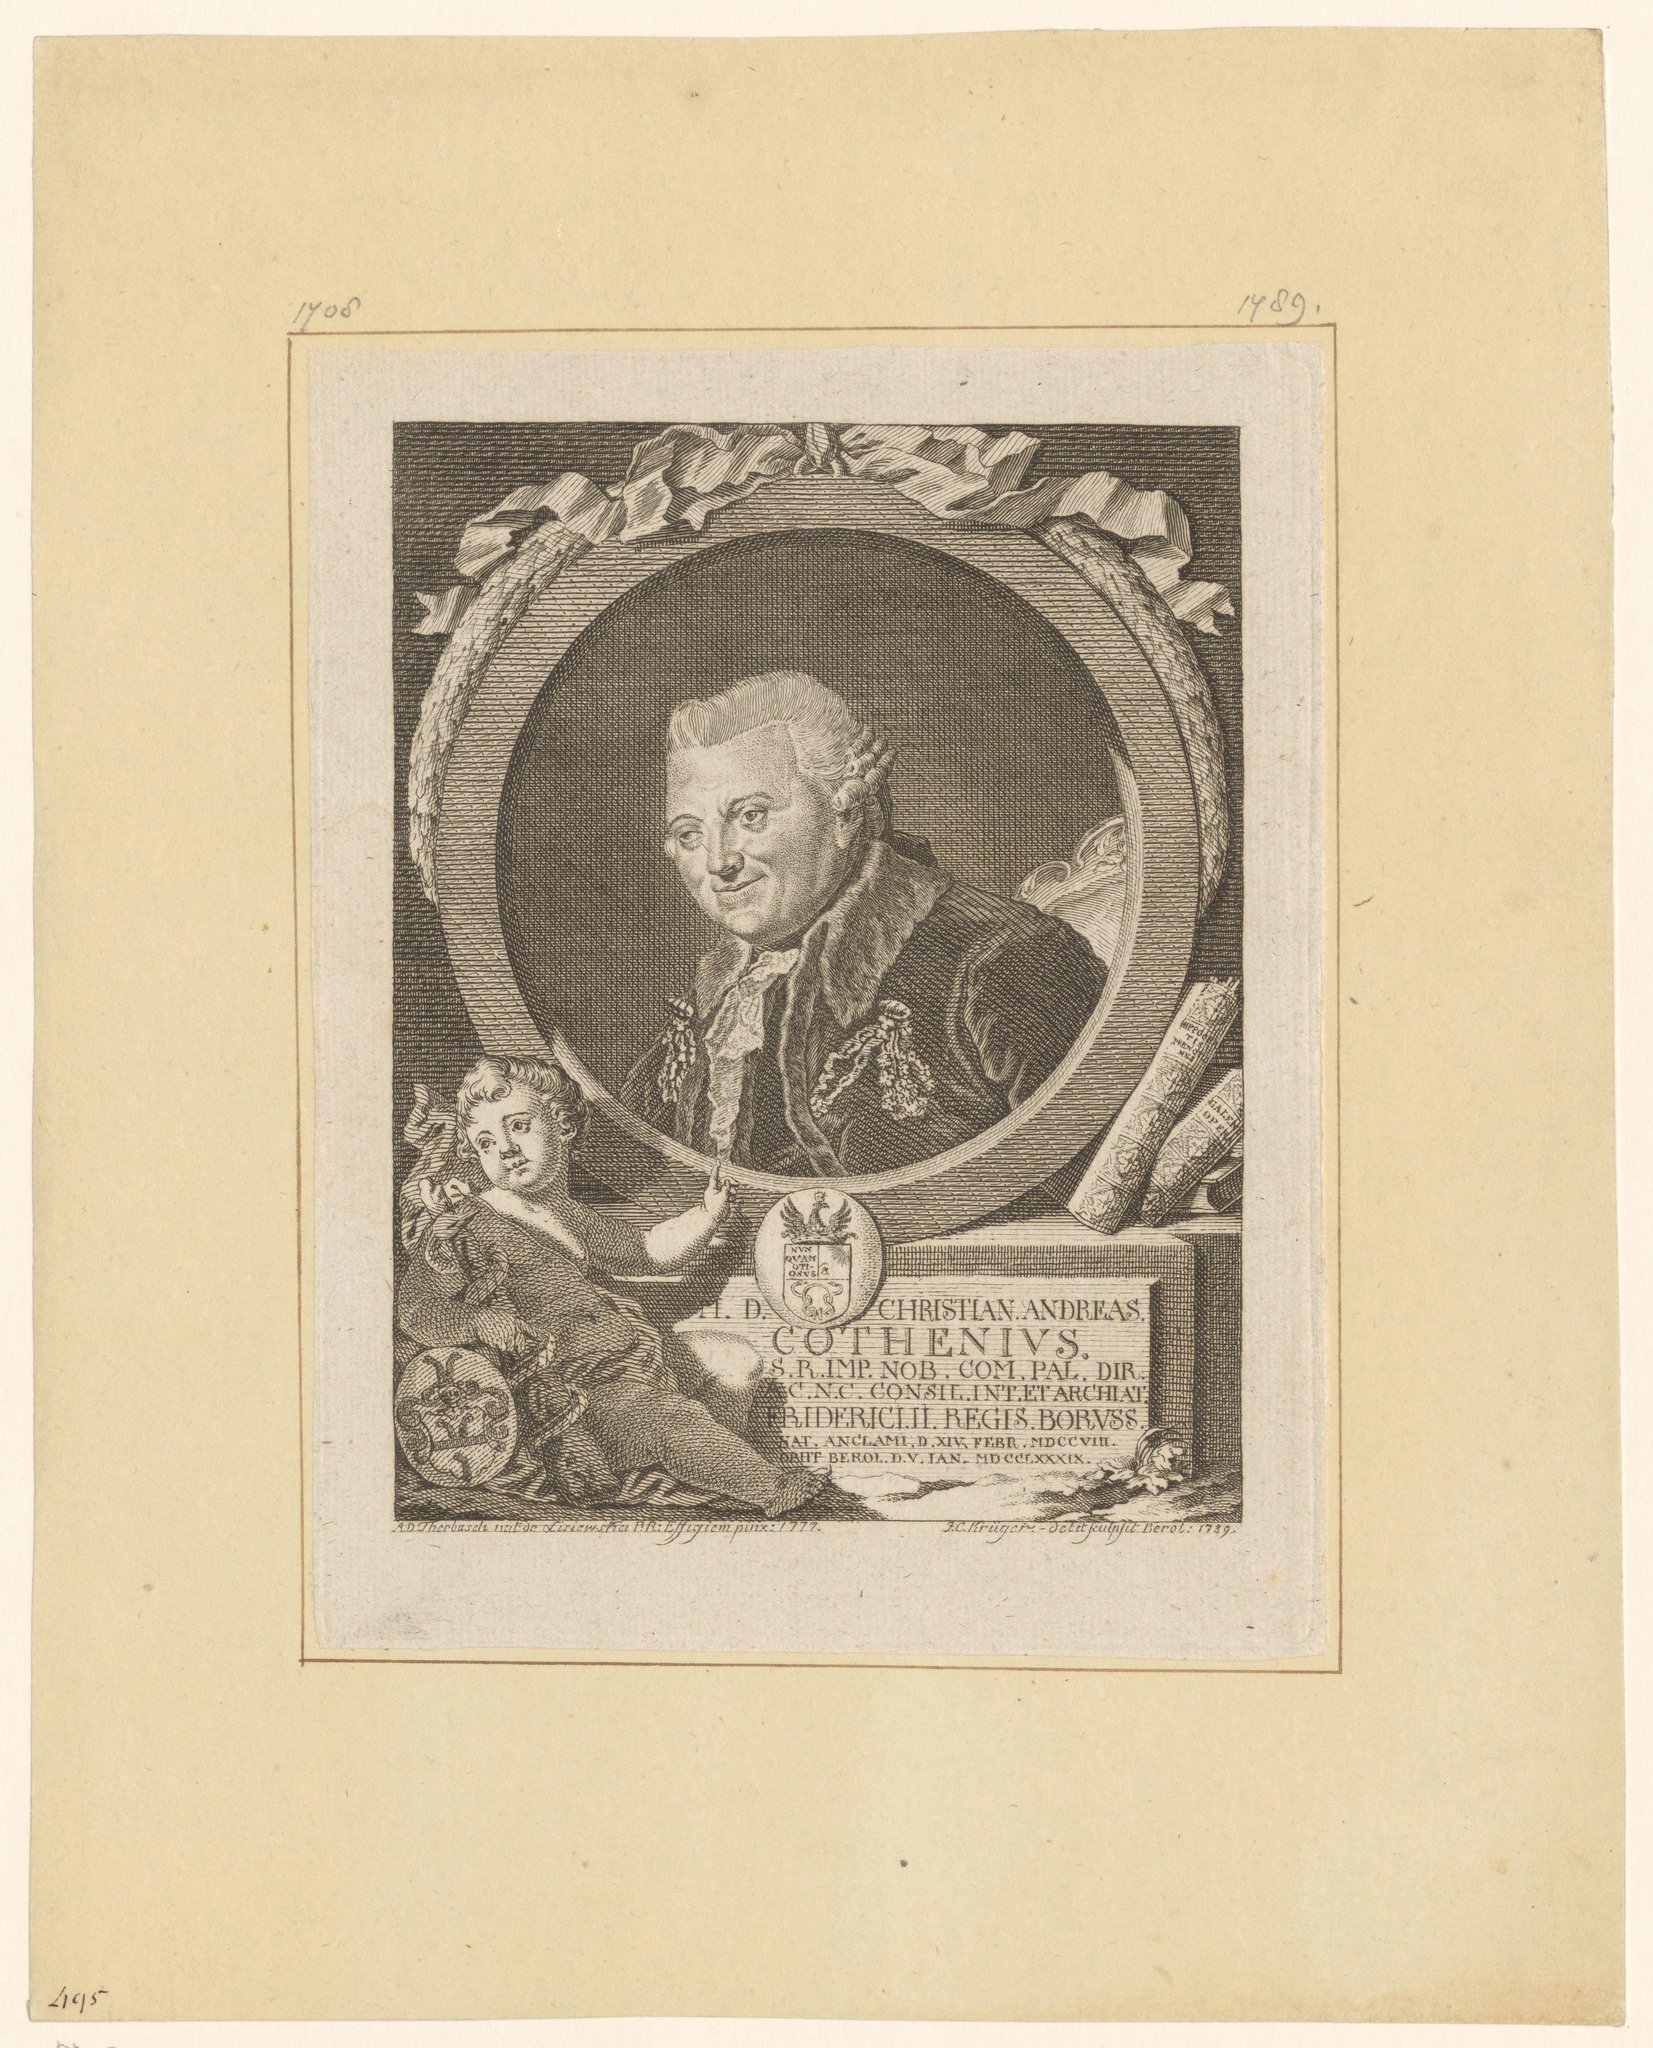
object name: print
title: Portret van Christian Andreas Cothenius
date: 1789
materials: paper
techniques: engraving, etching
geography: berlin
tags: berlin, historical persons, physician, doctor (+ portrait of scholar, scientist), caduceus (staff with two snakes, attribute of mercury)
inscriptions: collector's mark: Lugt 2228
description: Tekst in het Latijn op de sokkel en op de kaften van de boeken in de voorstelling.